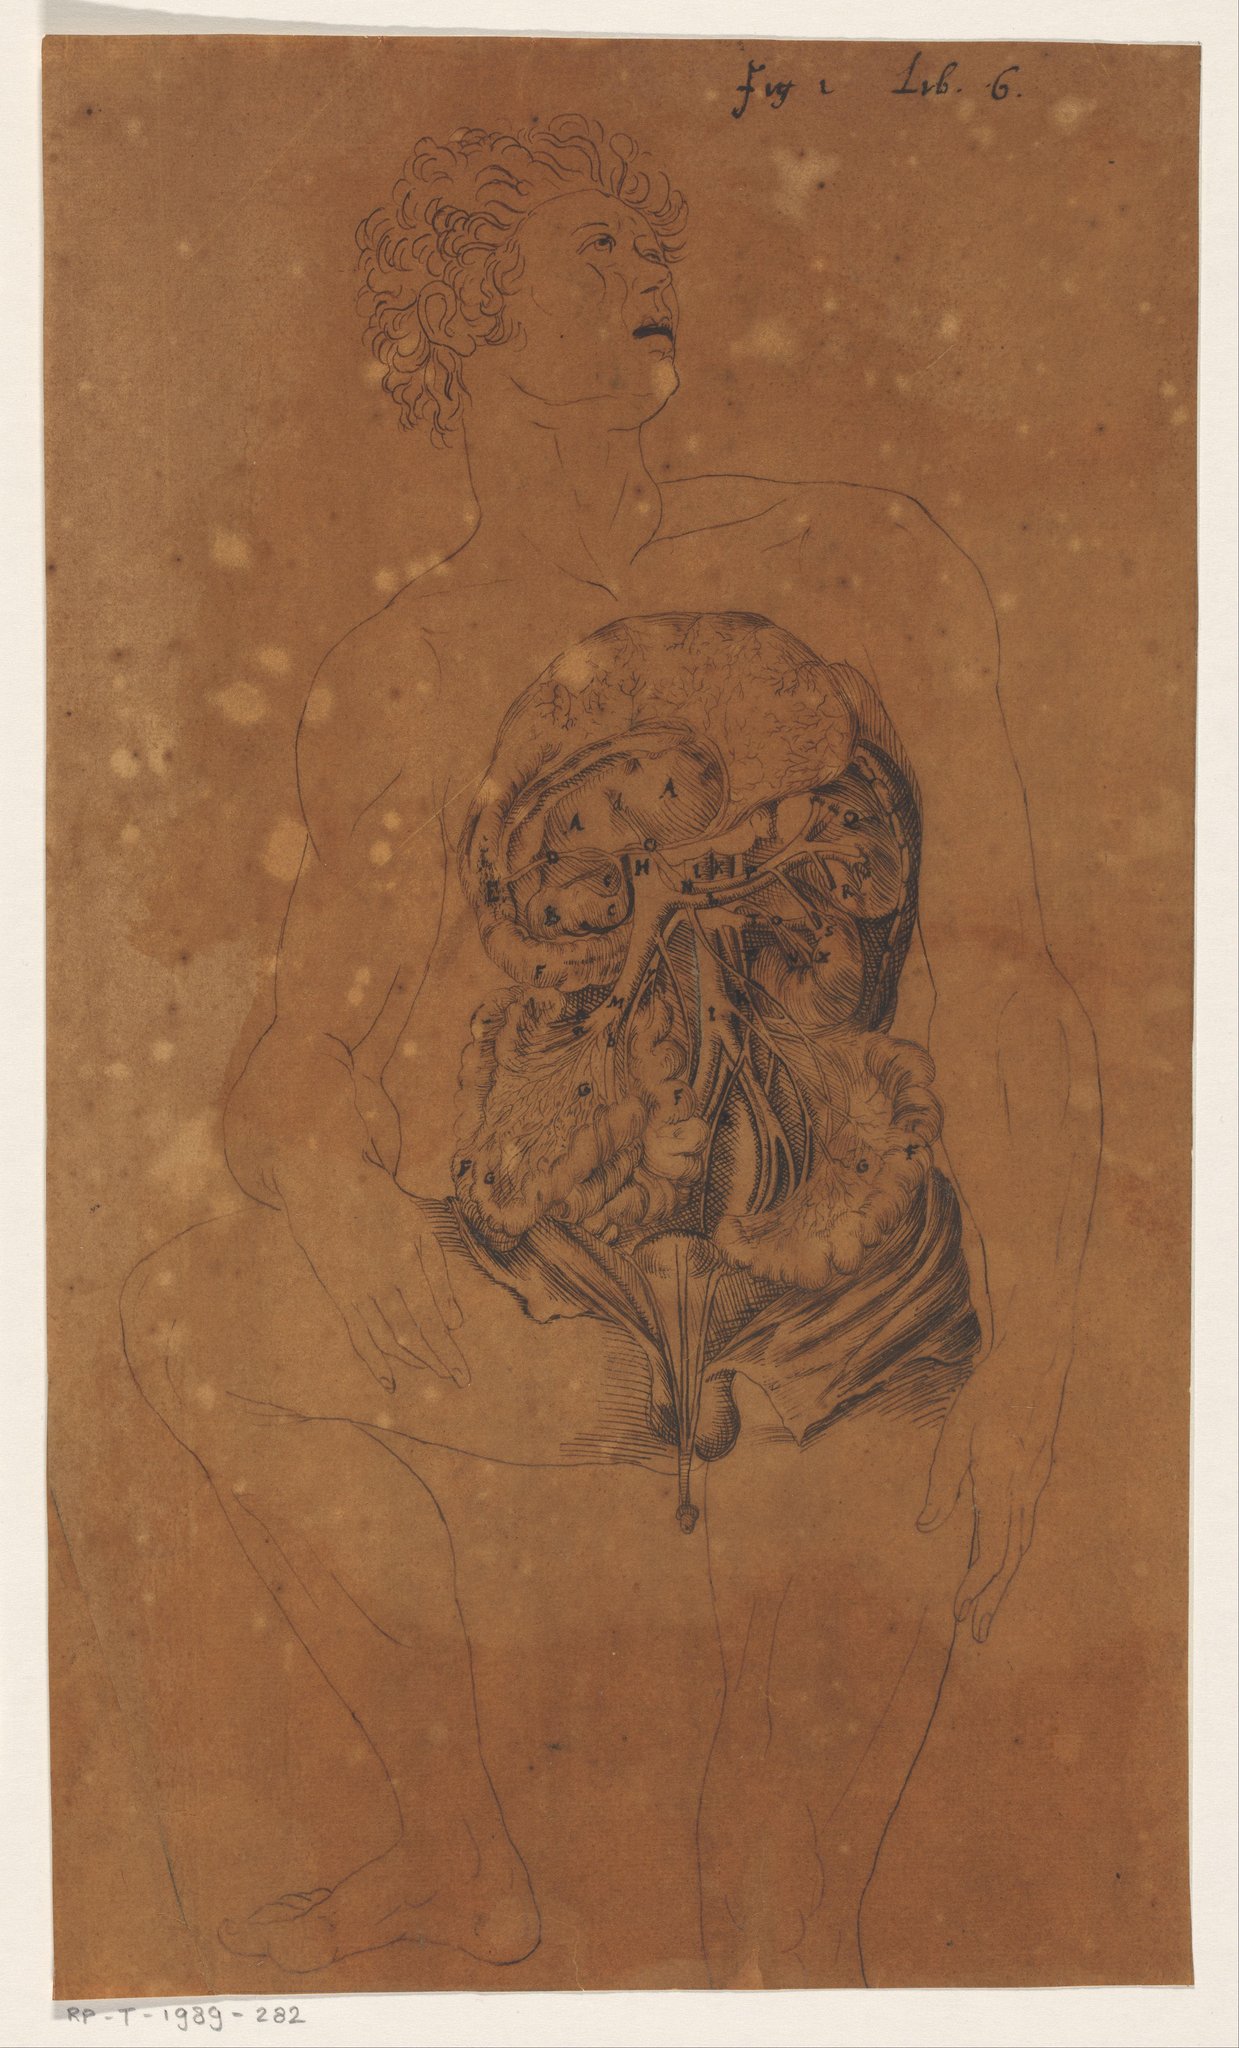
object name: drawing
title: Ingewanden van een man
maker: Anonymous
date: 1630-1649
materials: ink, paper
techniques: pen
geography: low countries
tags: intestines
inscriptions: collector's mark: Lugt 2228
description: De tekening en de letters die de verschillende onderdelen aanduiden komen overeen met een prent uit: Spiegel, Adriaan van den, en Daniel Bucretius. De humani corporis fabrica libri decem. Venetië: s.n., 1627. Tekening zit in een omslag met meerdere anatomische tekeningen, genummerd RP-T-1989-256 en RP-T-1989-258 t/m RP-T-1989-289.